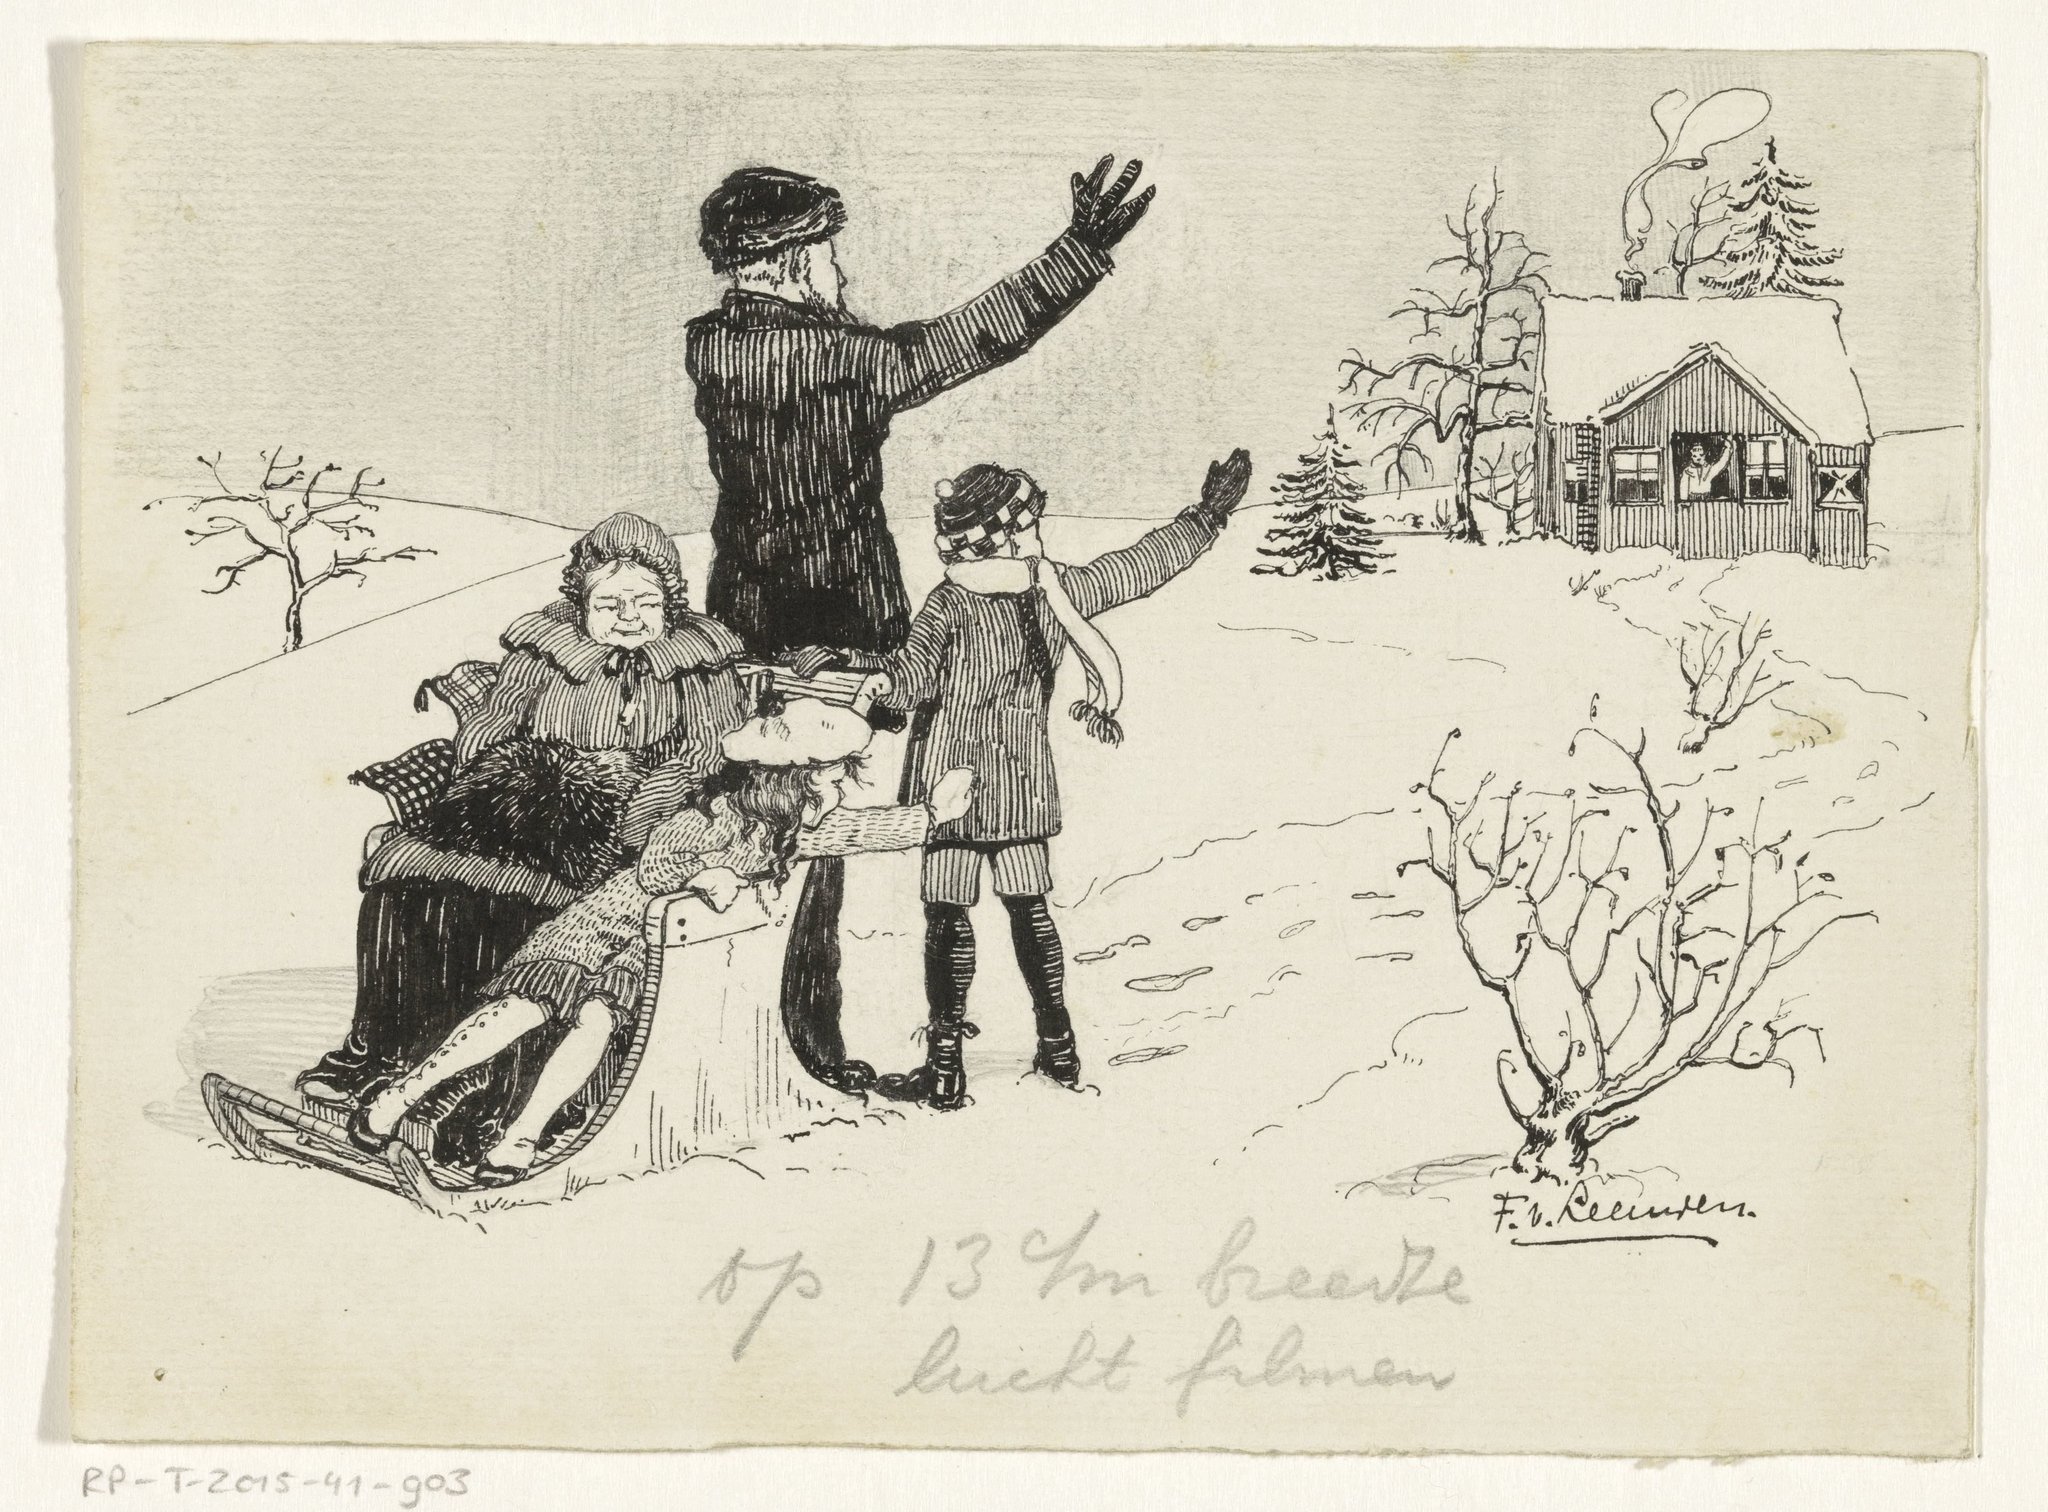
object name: boekillustratie ontwerp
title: Sneeuwlandschap met zwaaiende figuren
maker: f. van leeuwen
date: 1890-1970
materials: ink, paper, pencil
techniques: pen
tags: sleigh, sledge (non-sport), snow, farm or solitary house in landscape, waving farewell ~ departure on a journey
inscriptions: collector's mark: Lugt 2228, :, signature: ‘F. v.Leeuwen.’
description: In een besneeuwd landschap staan een man en jongen bij een slee waarop een meisje en vrouw zitten. De groep zwaait naar een figuur in het raam van een huis in de verte. Pennenstreken en arceringen op verso.